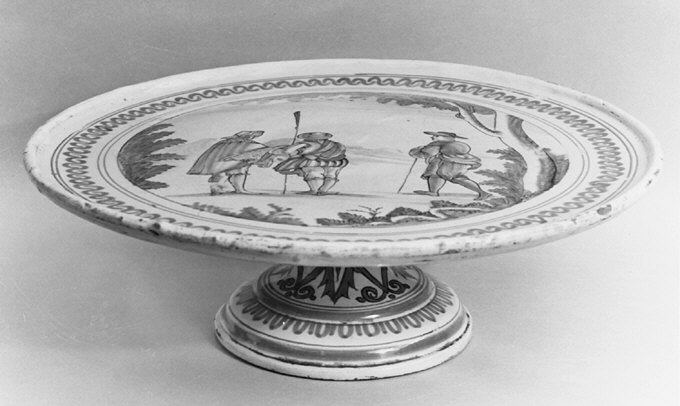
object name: tazza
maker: saint-jean-du-désert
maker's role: factory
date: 1651-1700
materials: faience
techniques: glazing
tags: men